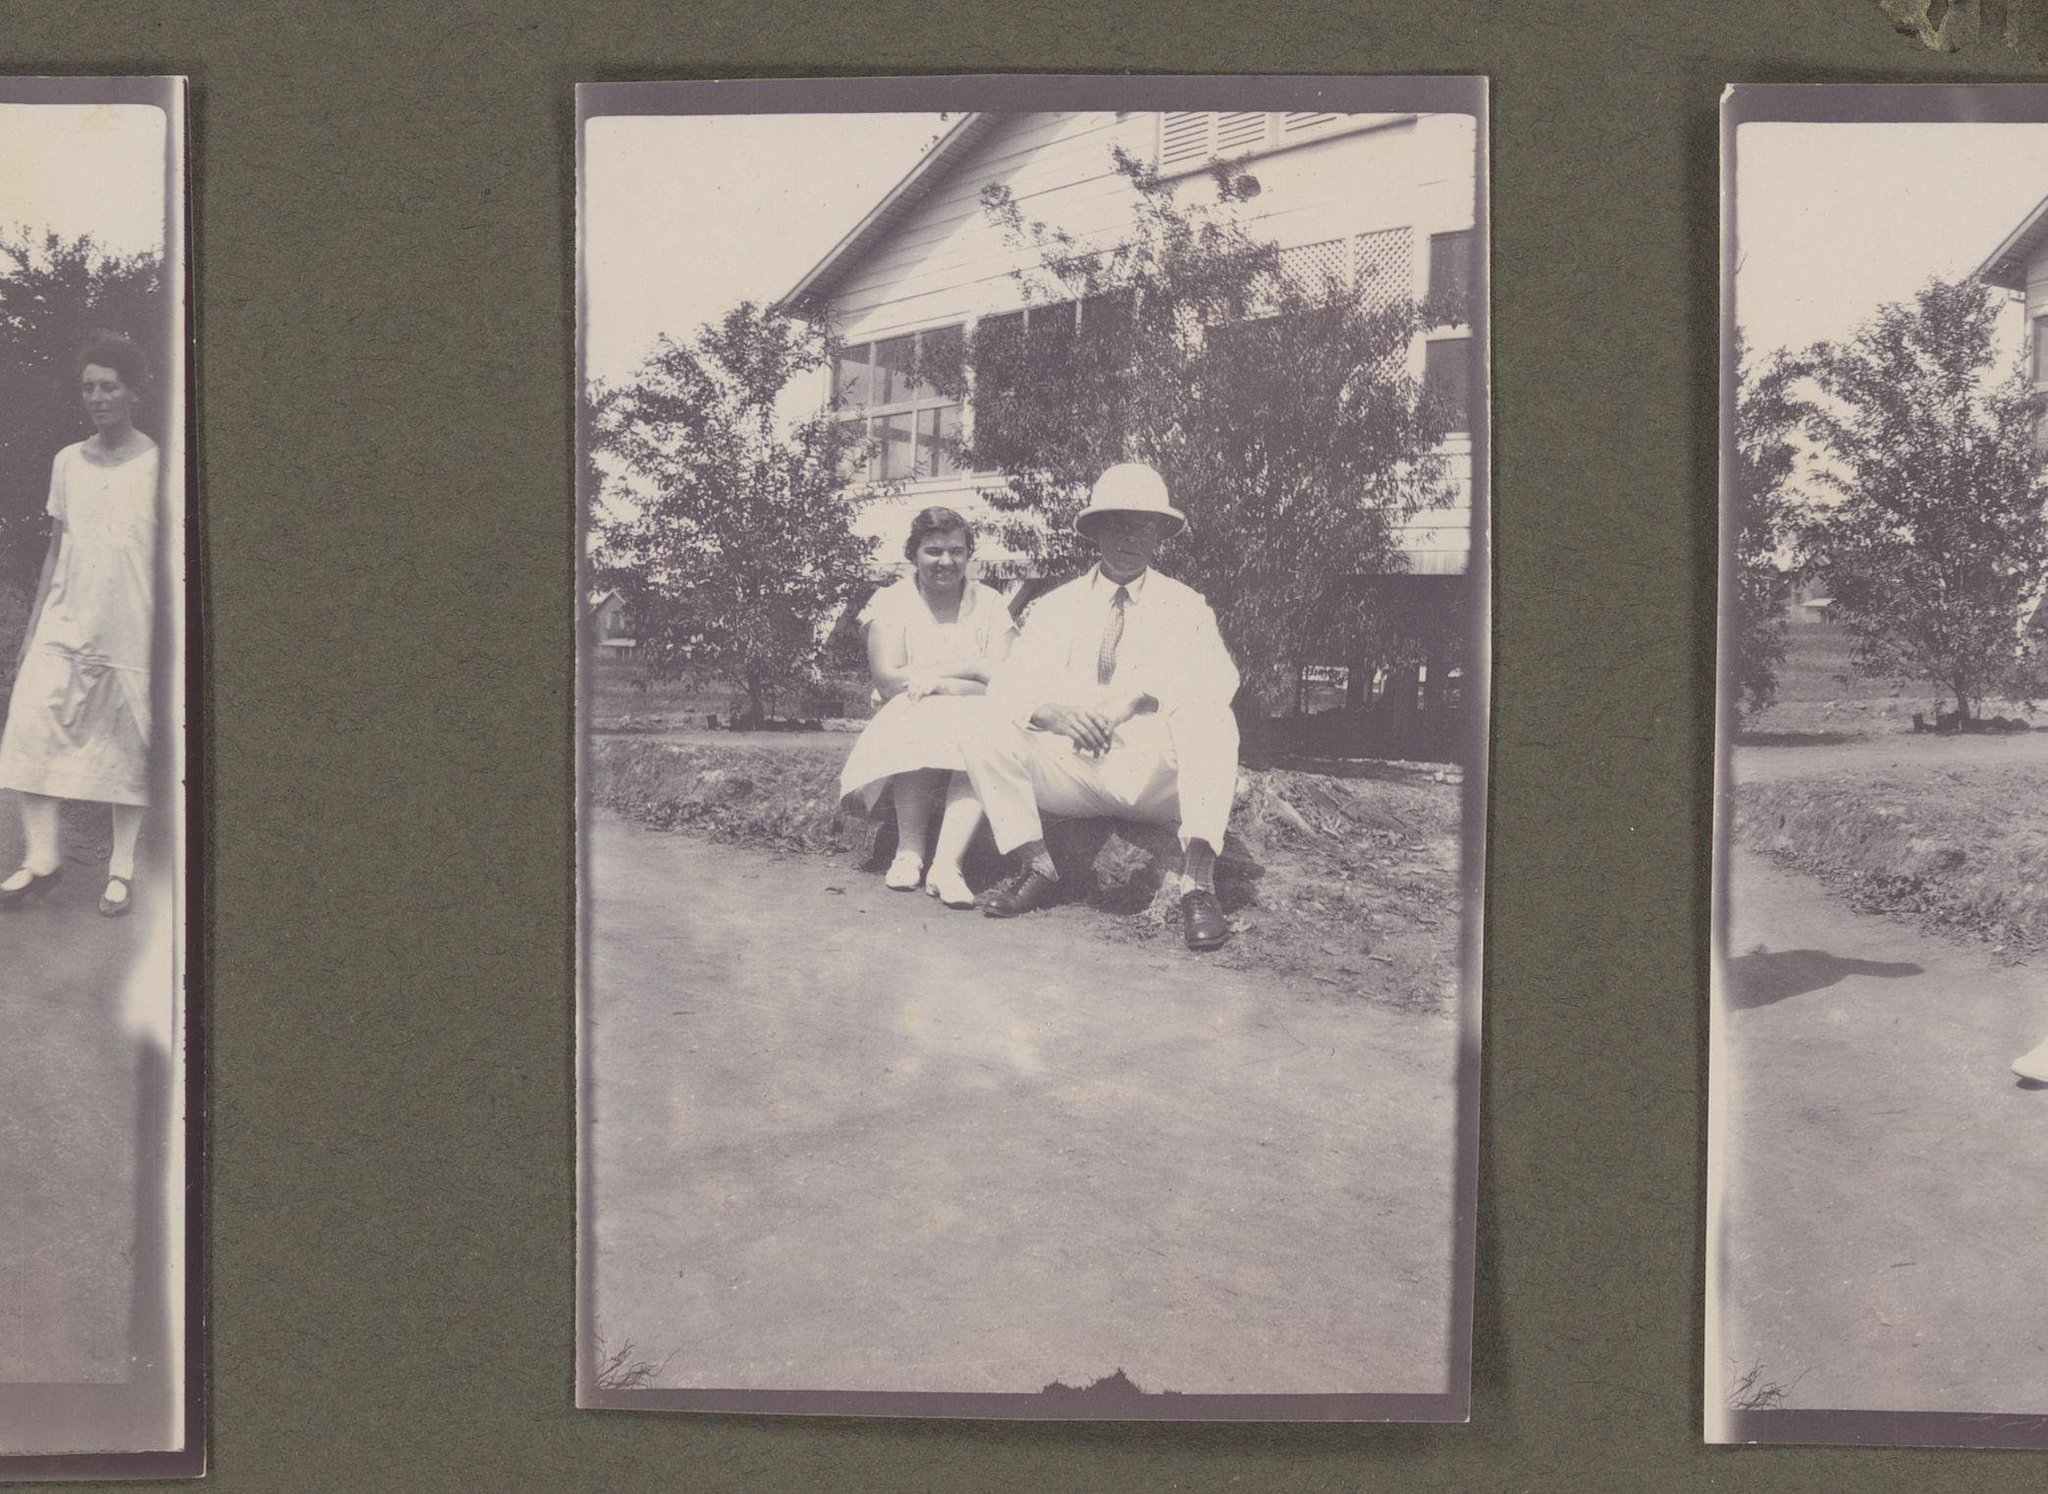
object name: photograph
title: Familiefoto te Moengo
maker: Anonymous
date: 1925-1927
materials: photographic support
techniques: photography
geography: suriname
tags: jetten, familie, moengo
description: Familiefoto met een echtpaar te Moengo. Foto op een bladzijde van een los albumblad. Onderdeel van het ensemble met foto's van de familie van ingenieur Jetten in de mijnbouwstad Moengo in Suriname.